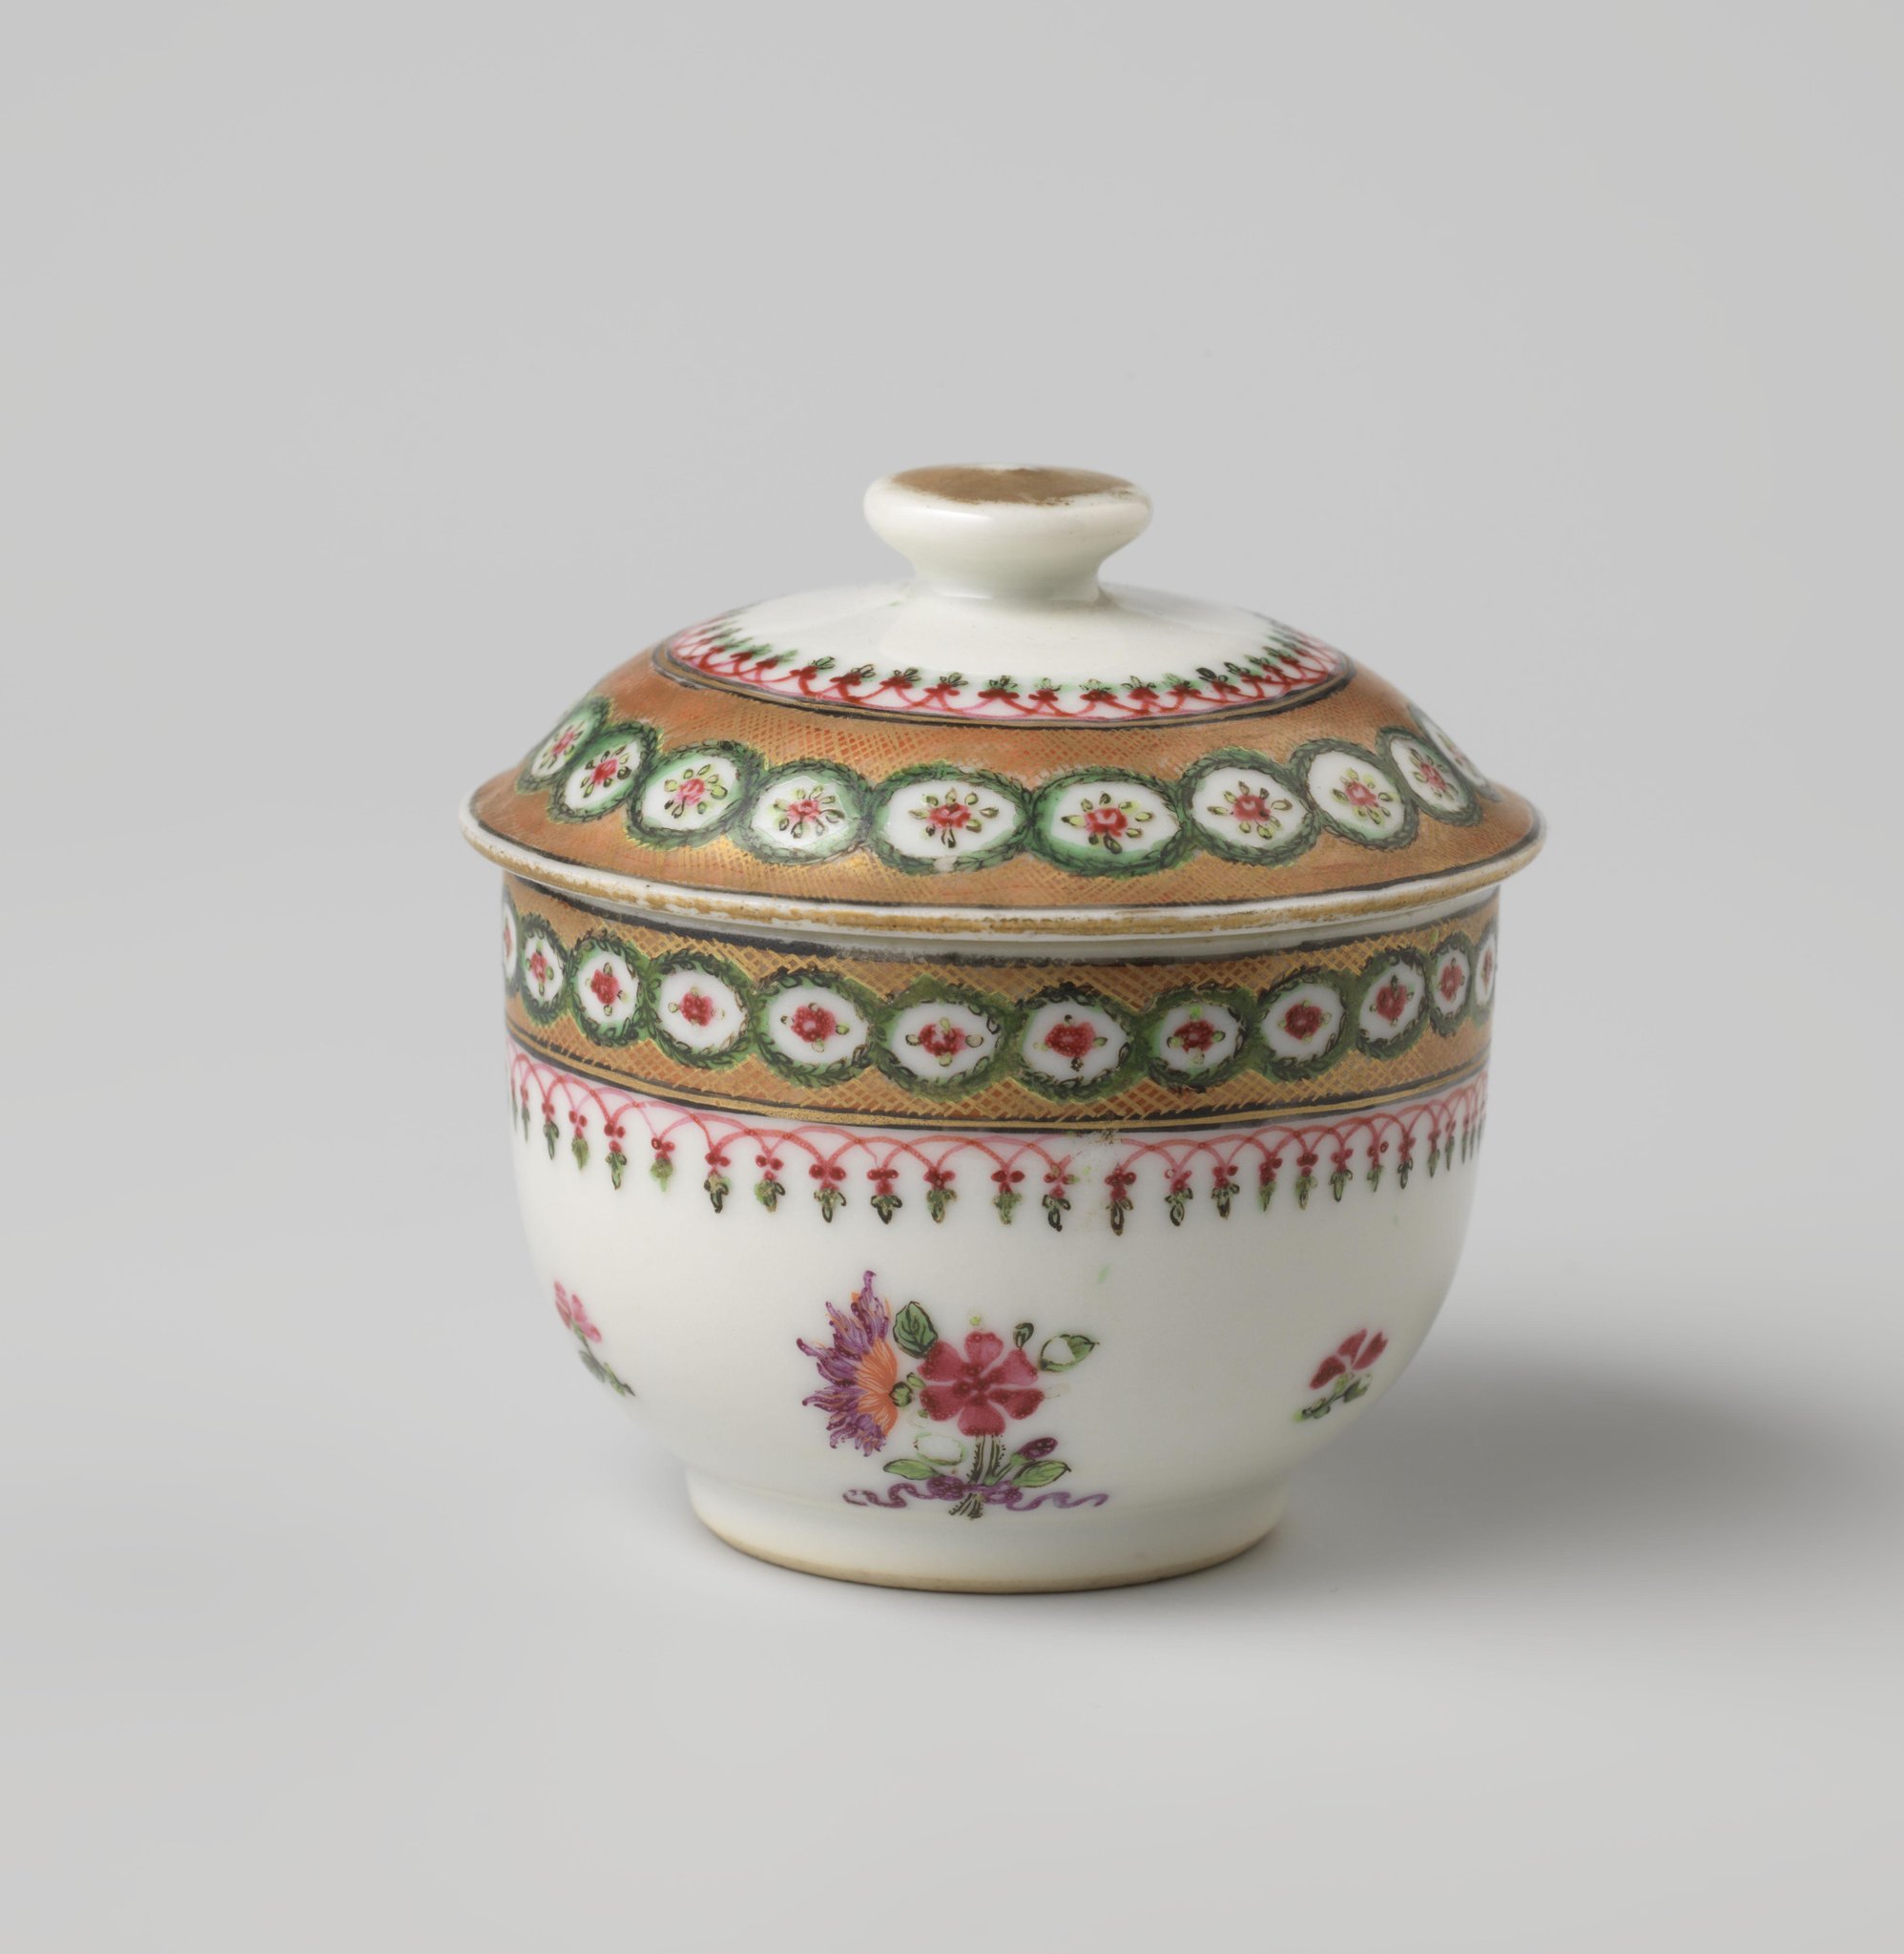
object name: lid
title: Covered jar with bouquets, scattered flowers and ornamental borders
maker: Anonymous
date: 1750-1774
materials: glaze, gold, paint, porcelain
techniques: firing, gilding, turning, vitrification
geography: china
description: Deksel van dekselkom van porselein met een platte knop, beschilderd op het glazuur in rood, roze, groen, paars, zwart en goud. Dm de buitenrand een brede decoratieve band met servetwerk en een band met bloemen en een 'spearhead-border'. Famille rose.